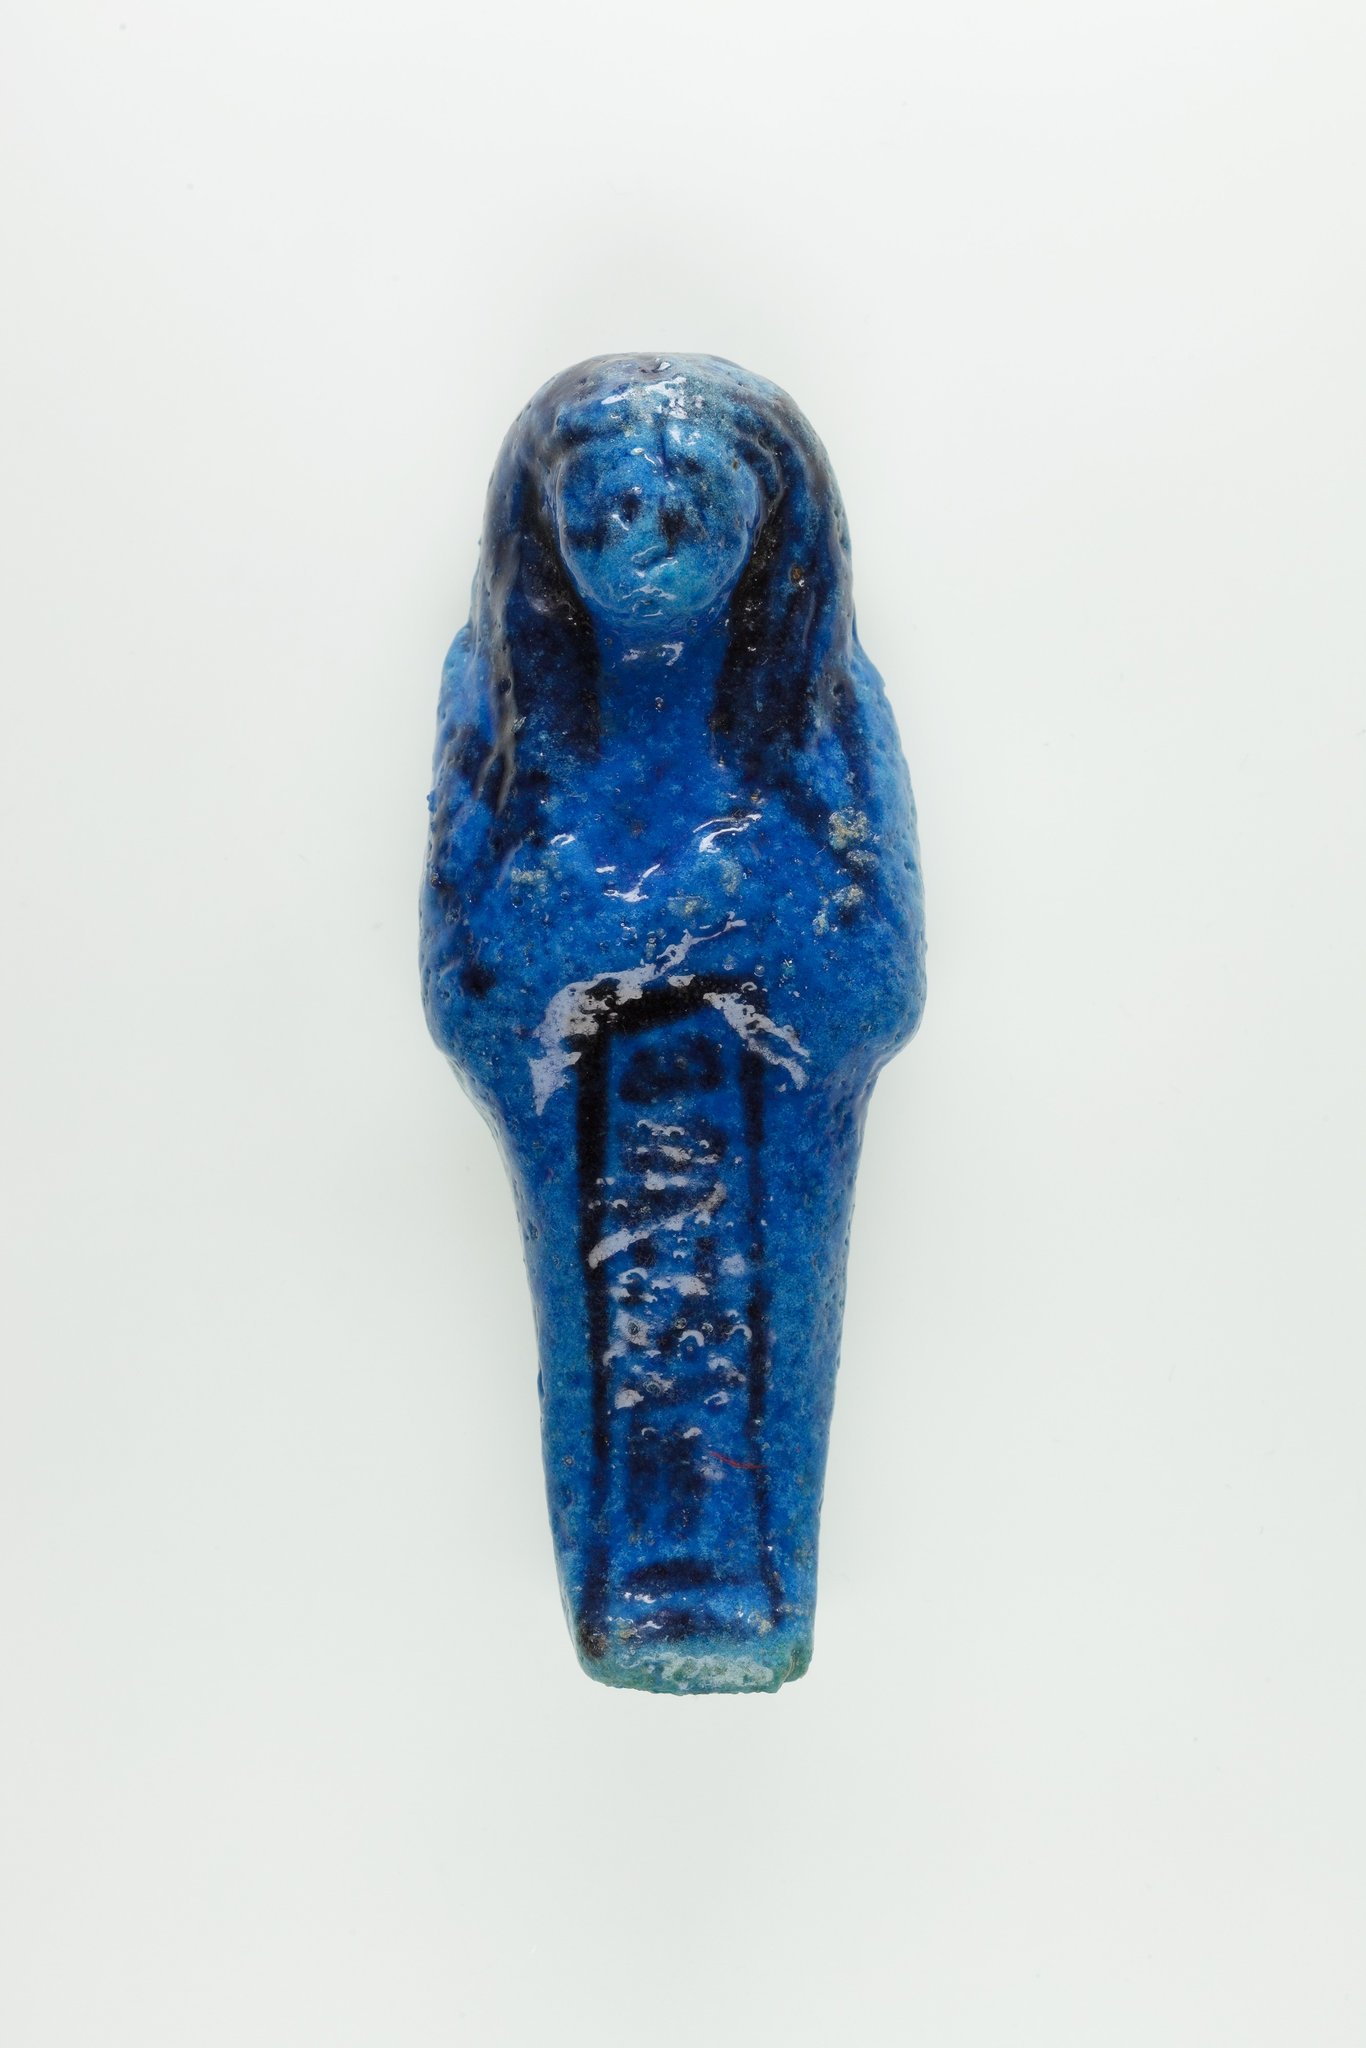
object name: shabti, worker, nauny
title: Worker Shabti of Nauny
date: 1050 BCE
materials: faience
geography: egypt